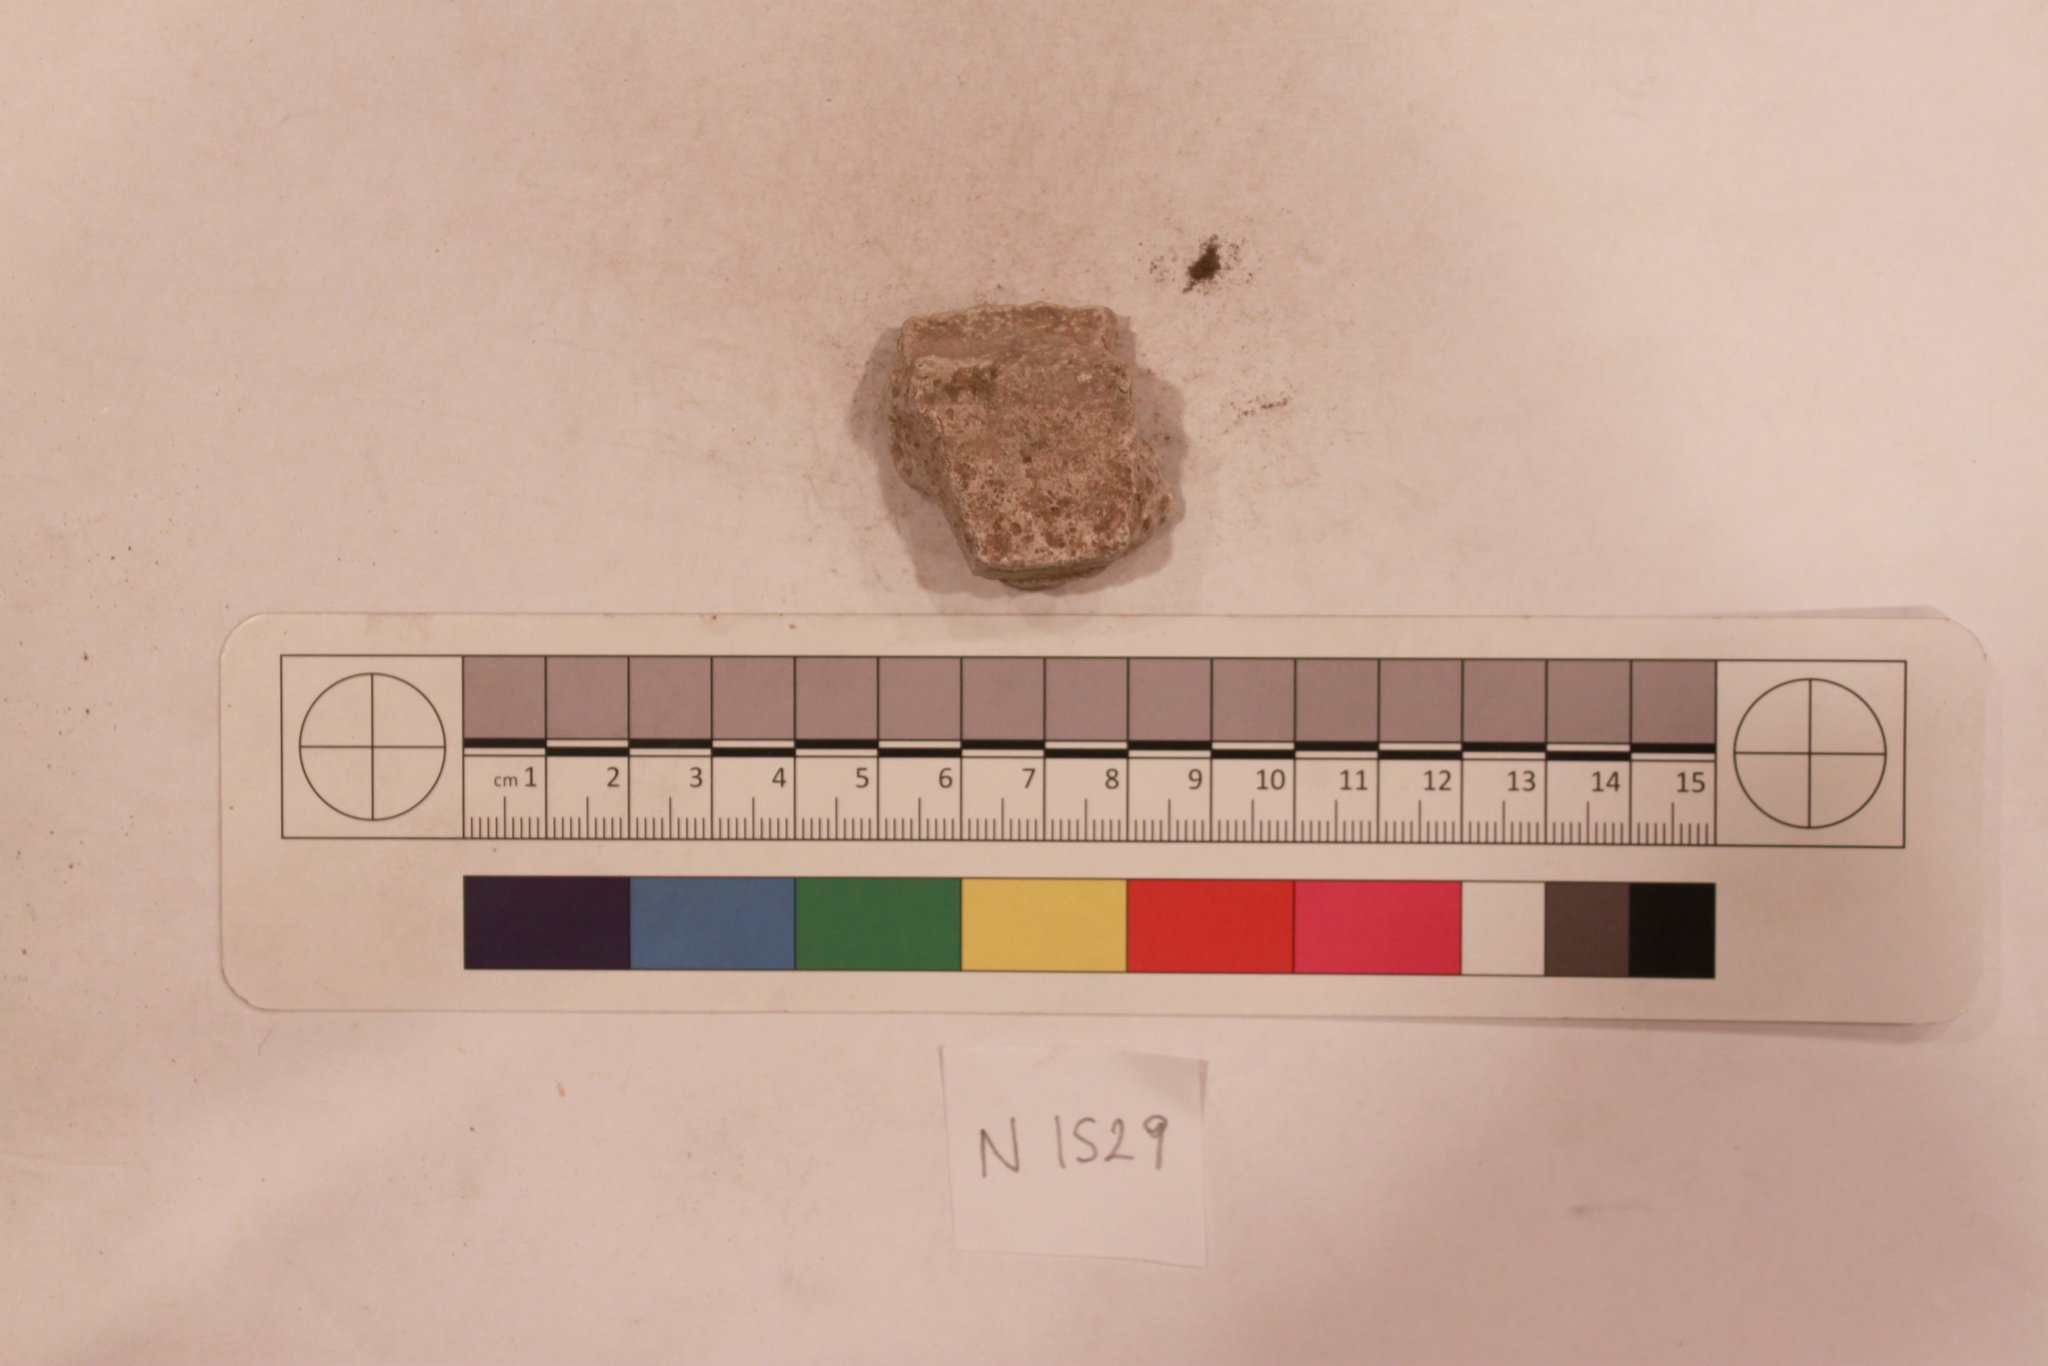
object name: fragment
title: Stucco Fragment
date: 701-1200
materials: plaster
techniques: carving, painting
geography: iran